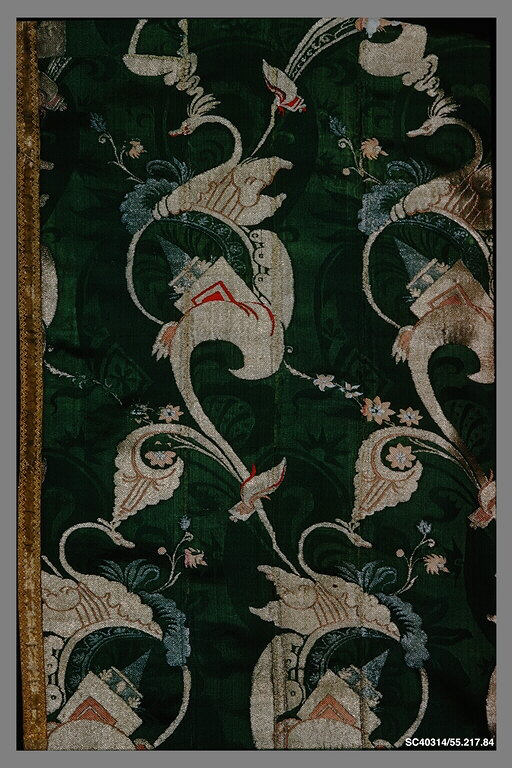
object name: piece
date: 1710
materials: metal thread, silk